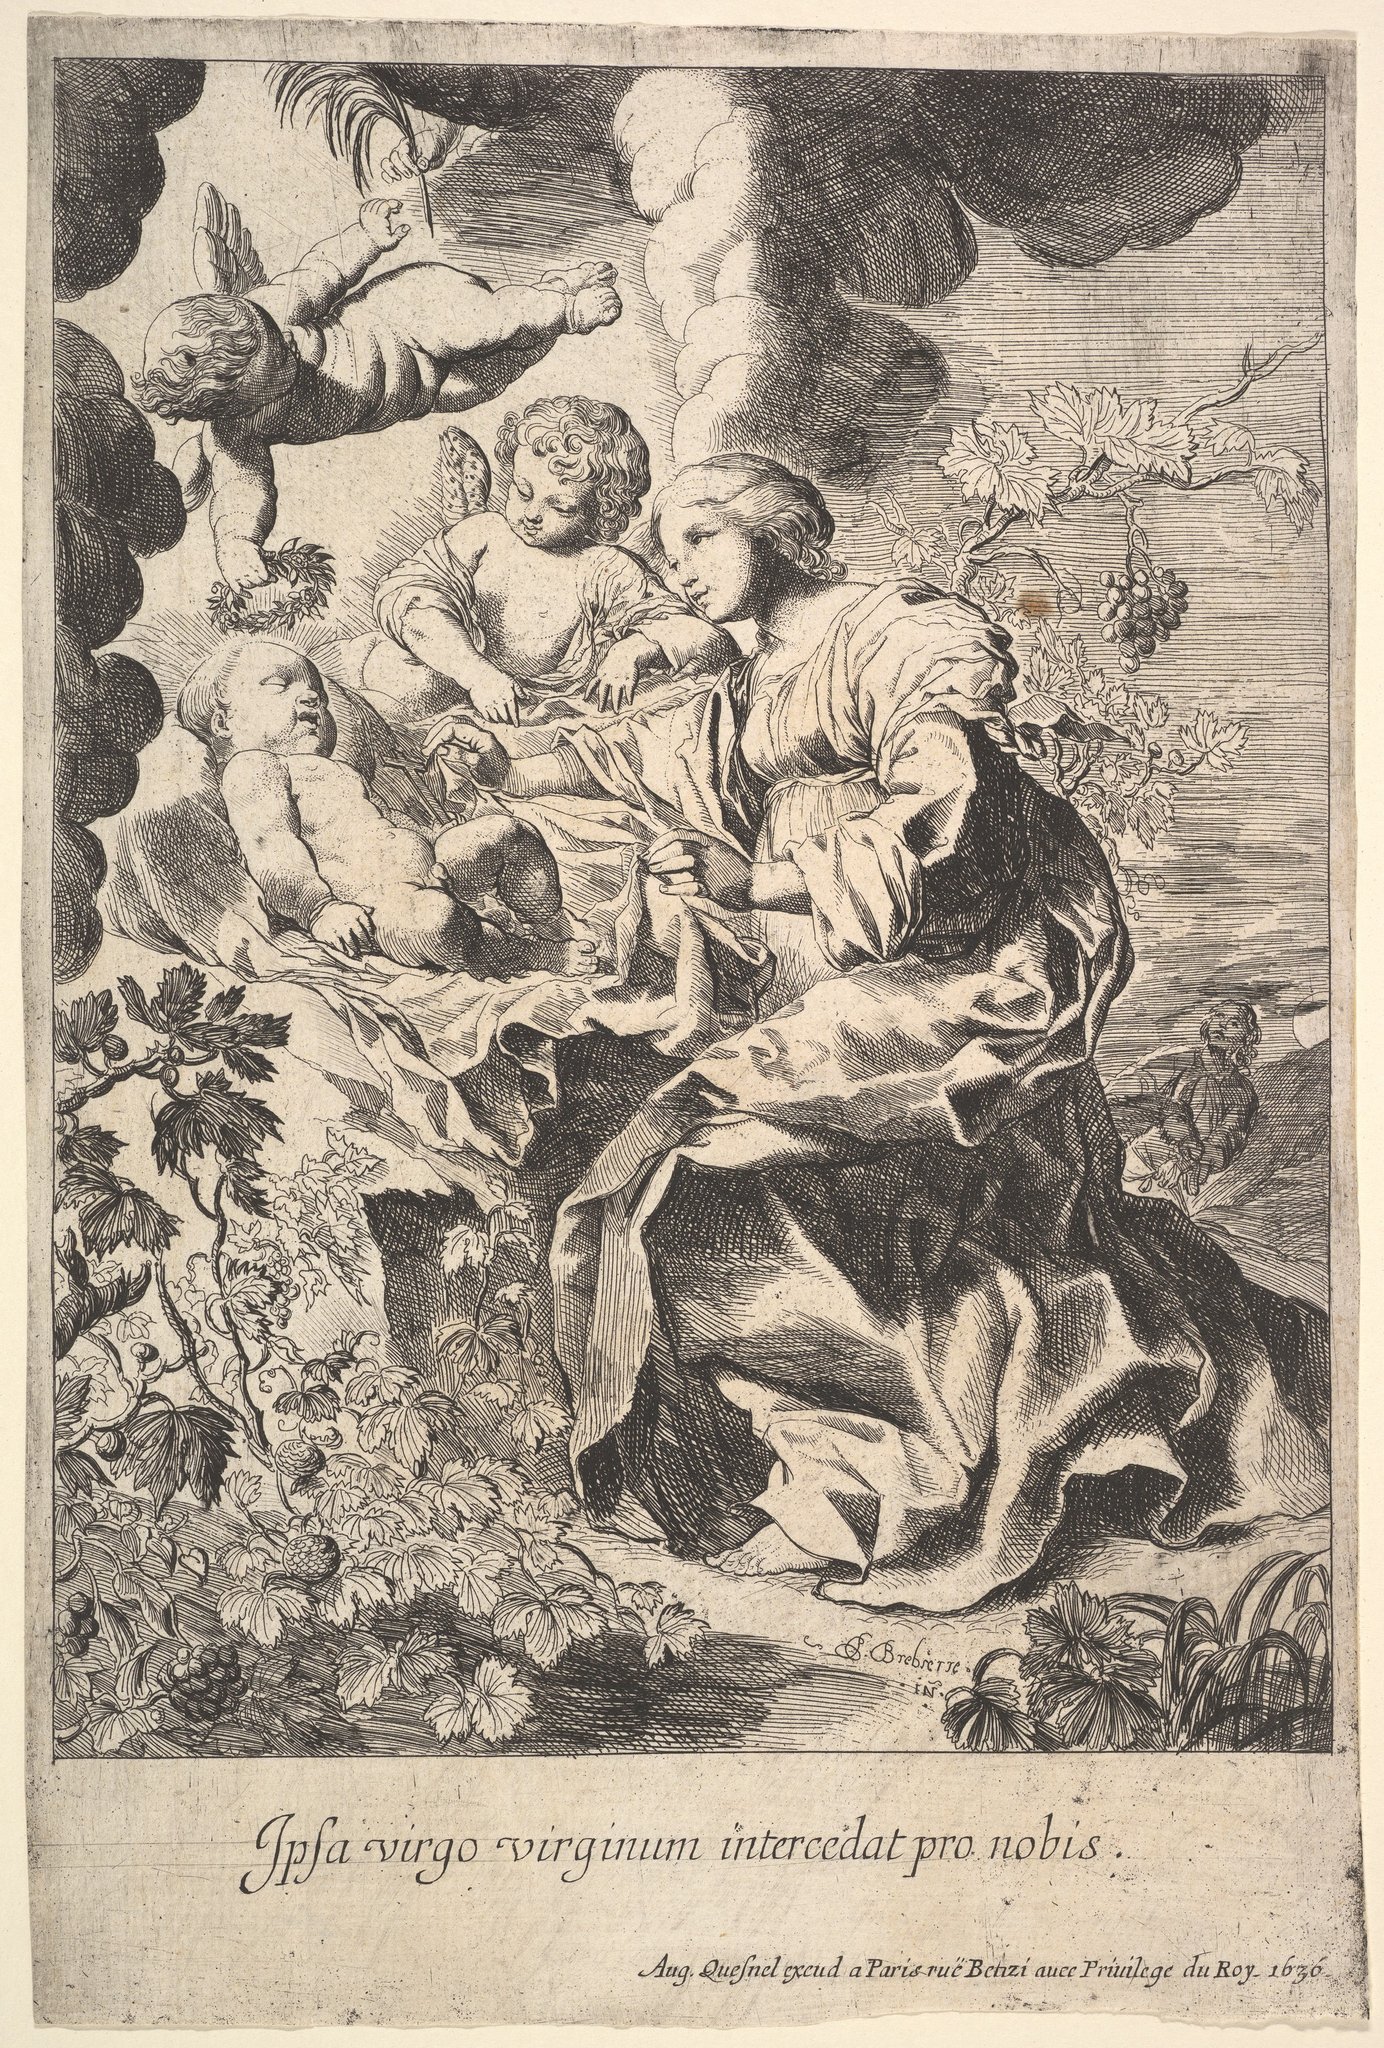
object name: print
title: Virgin and child with angels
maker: pierre brebiette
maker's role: artist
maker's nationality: french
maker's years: 1598-1642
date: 1636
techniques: etching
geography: france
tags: infants,leaves,angels,christ,virgin mary